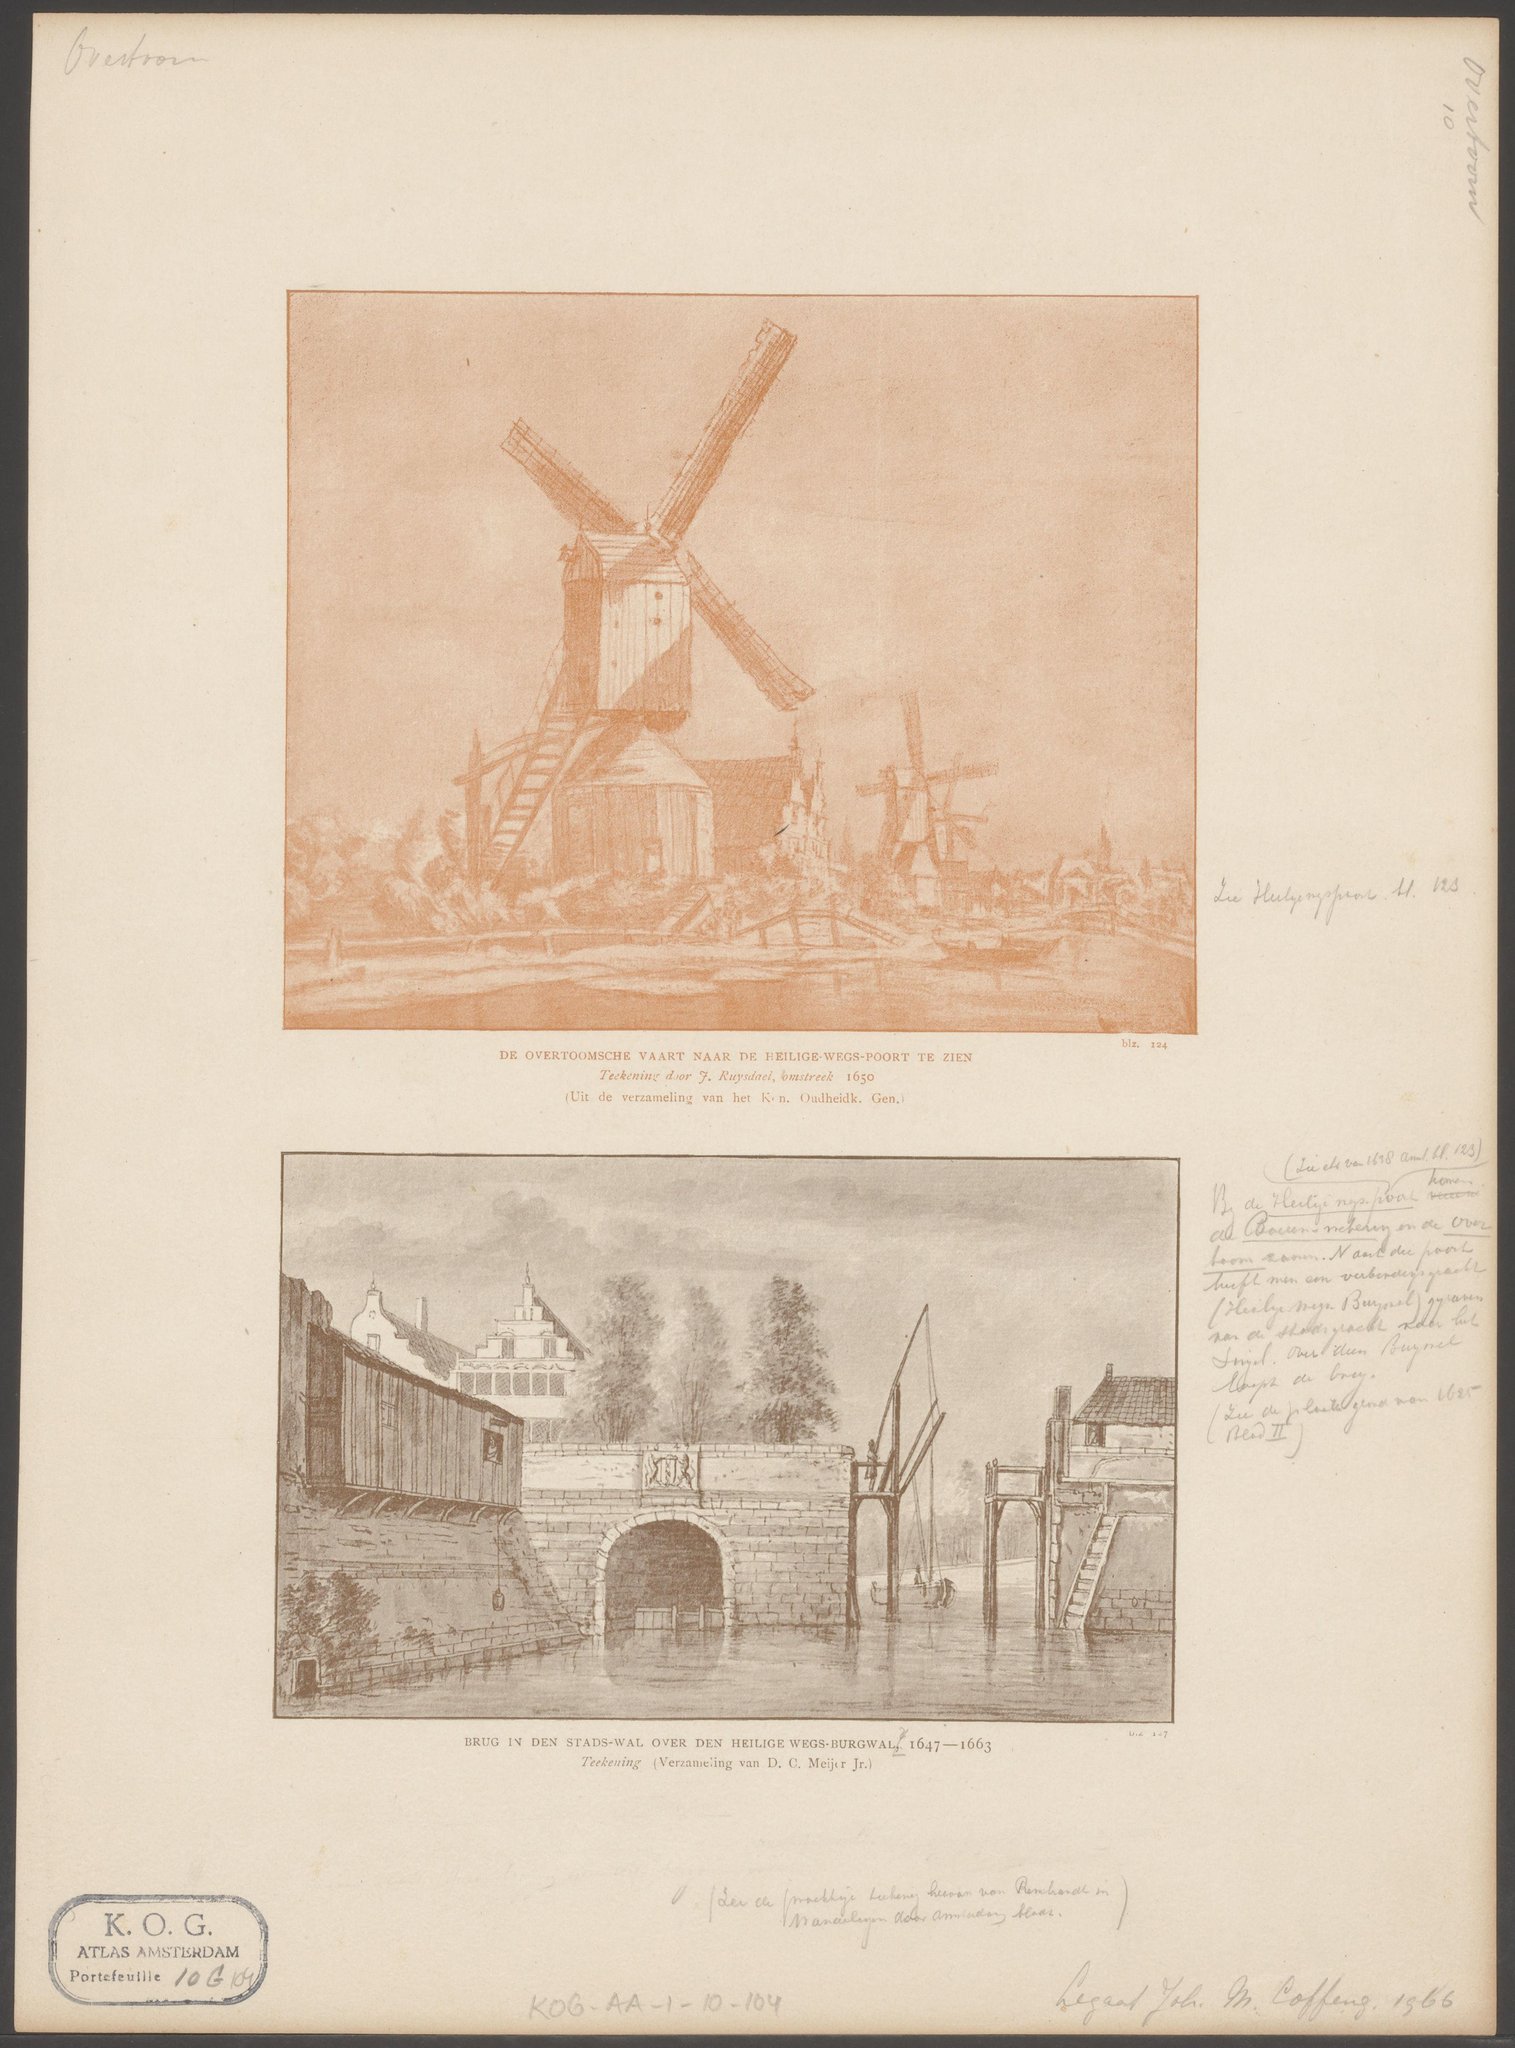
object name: photomechanical print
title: Gezichten van molens en bruggen langs de Overtoomse vaart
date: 1880-1950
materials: paper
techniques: autotype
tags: city-view in general; 'veduta', river, windmill in landscape, bridge in city across river, canal, etc., boat propelled by man or animal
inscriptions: inscription: ‘Overtoom / Overtoom / 10 (...) Joh. M. Coffeng. 1966’, collector's mark: ‘10G,104’ Lugt 1641b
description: Onderwerpsrubriek binnen de Atlas Amsterdam: Overtoom.